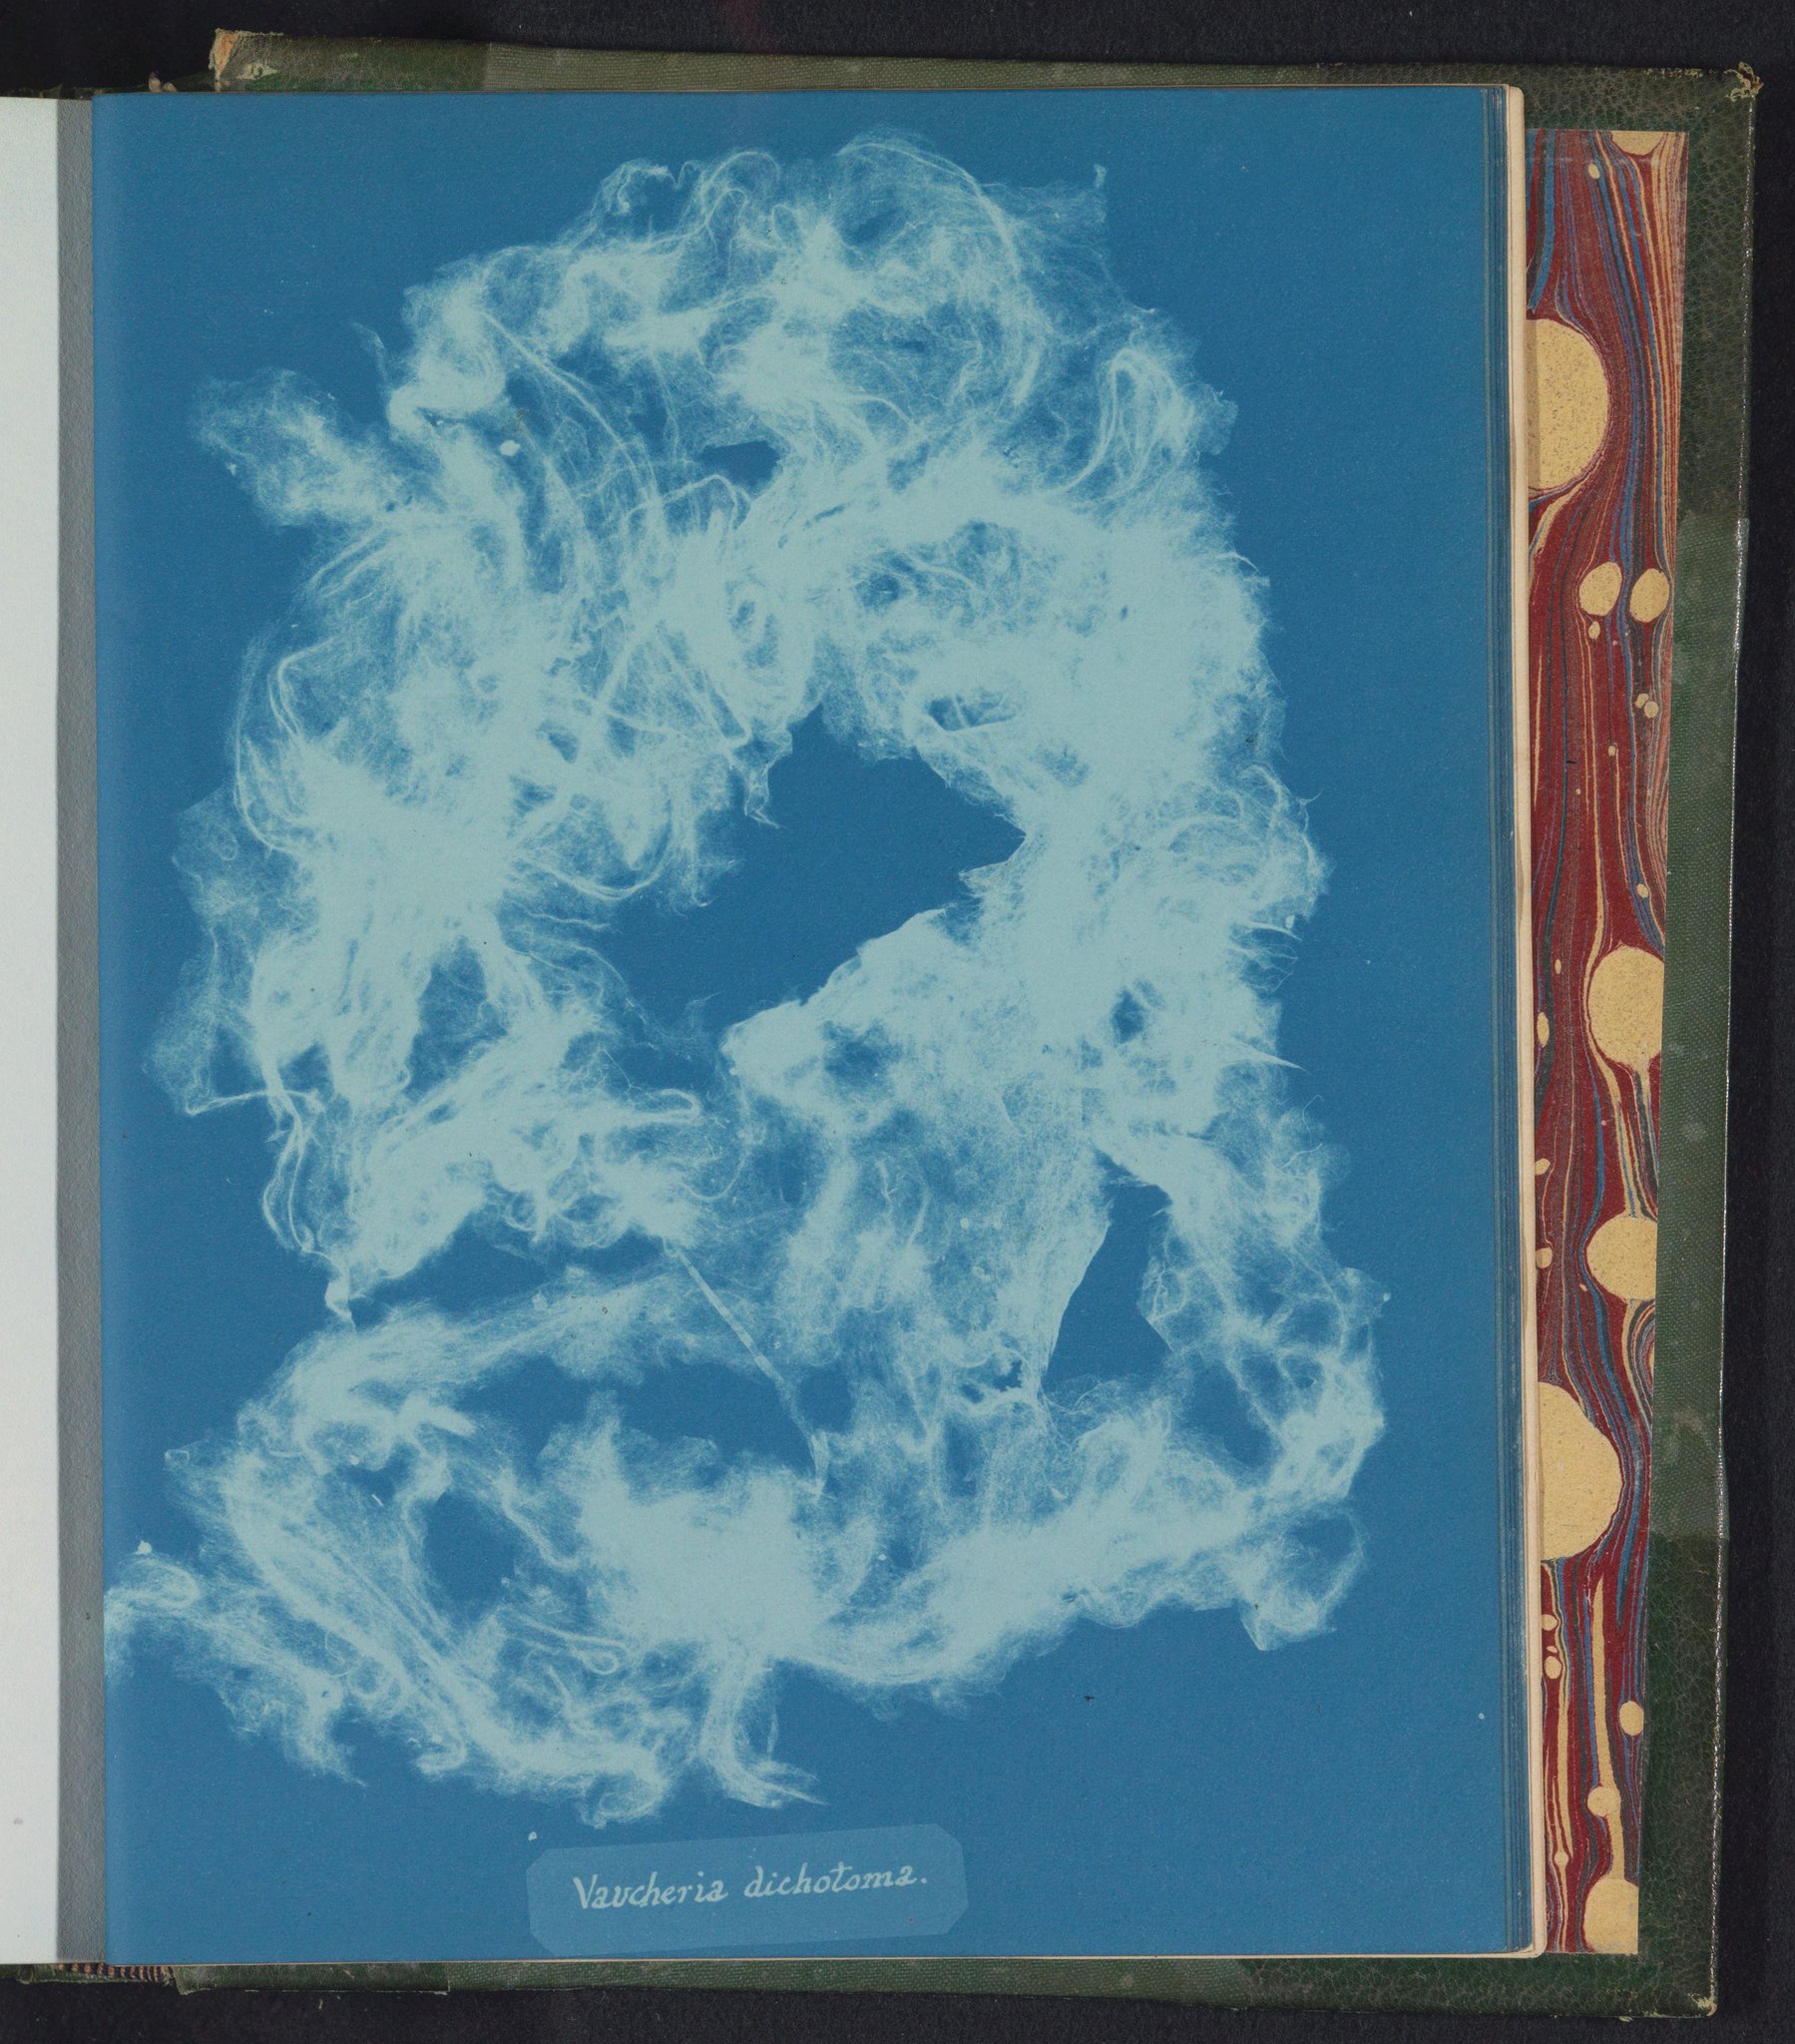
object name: photograph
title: Zeewier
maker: anna atkins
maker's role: fotograaf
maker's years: 1799-1871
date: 1843-1853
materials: photographic support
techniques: cyanotype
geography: united kingdom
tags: algae, seaweed